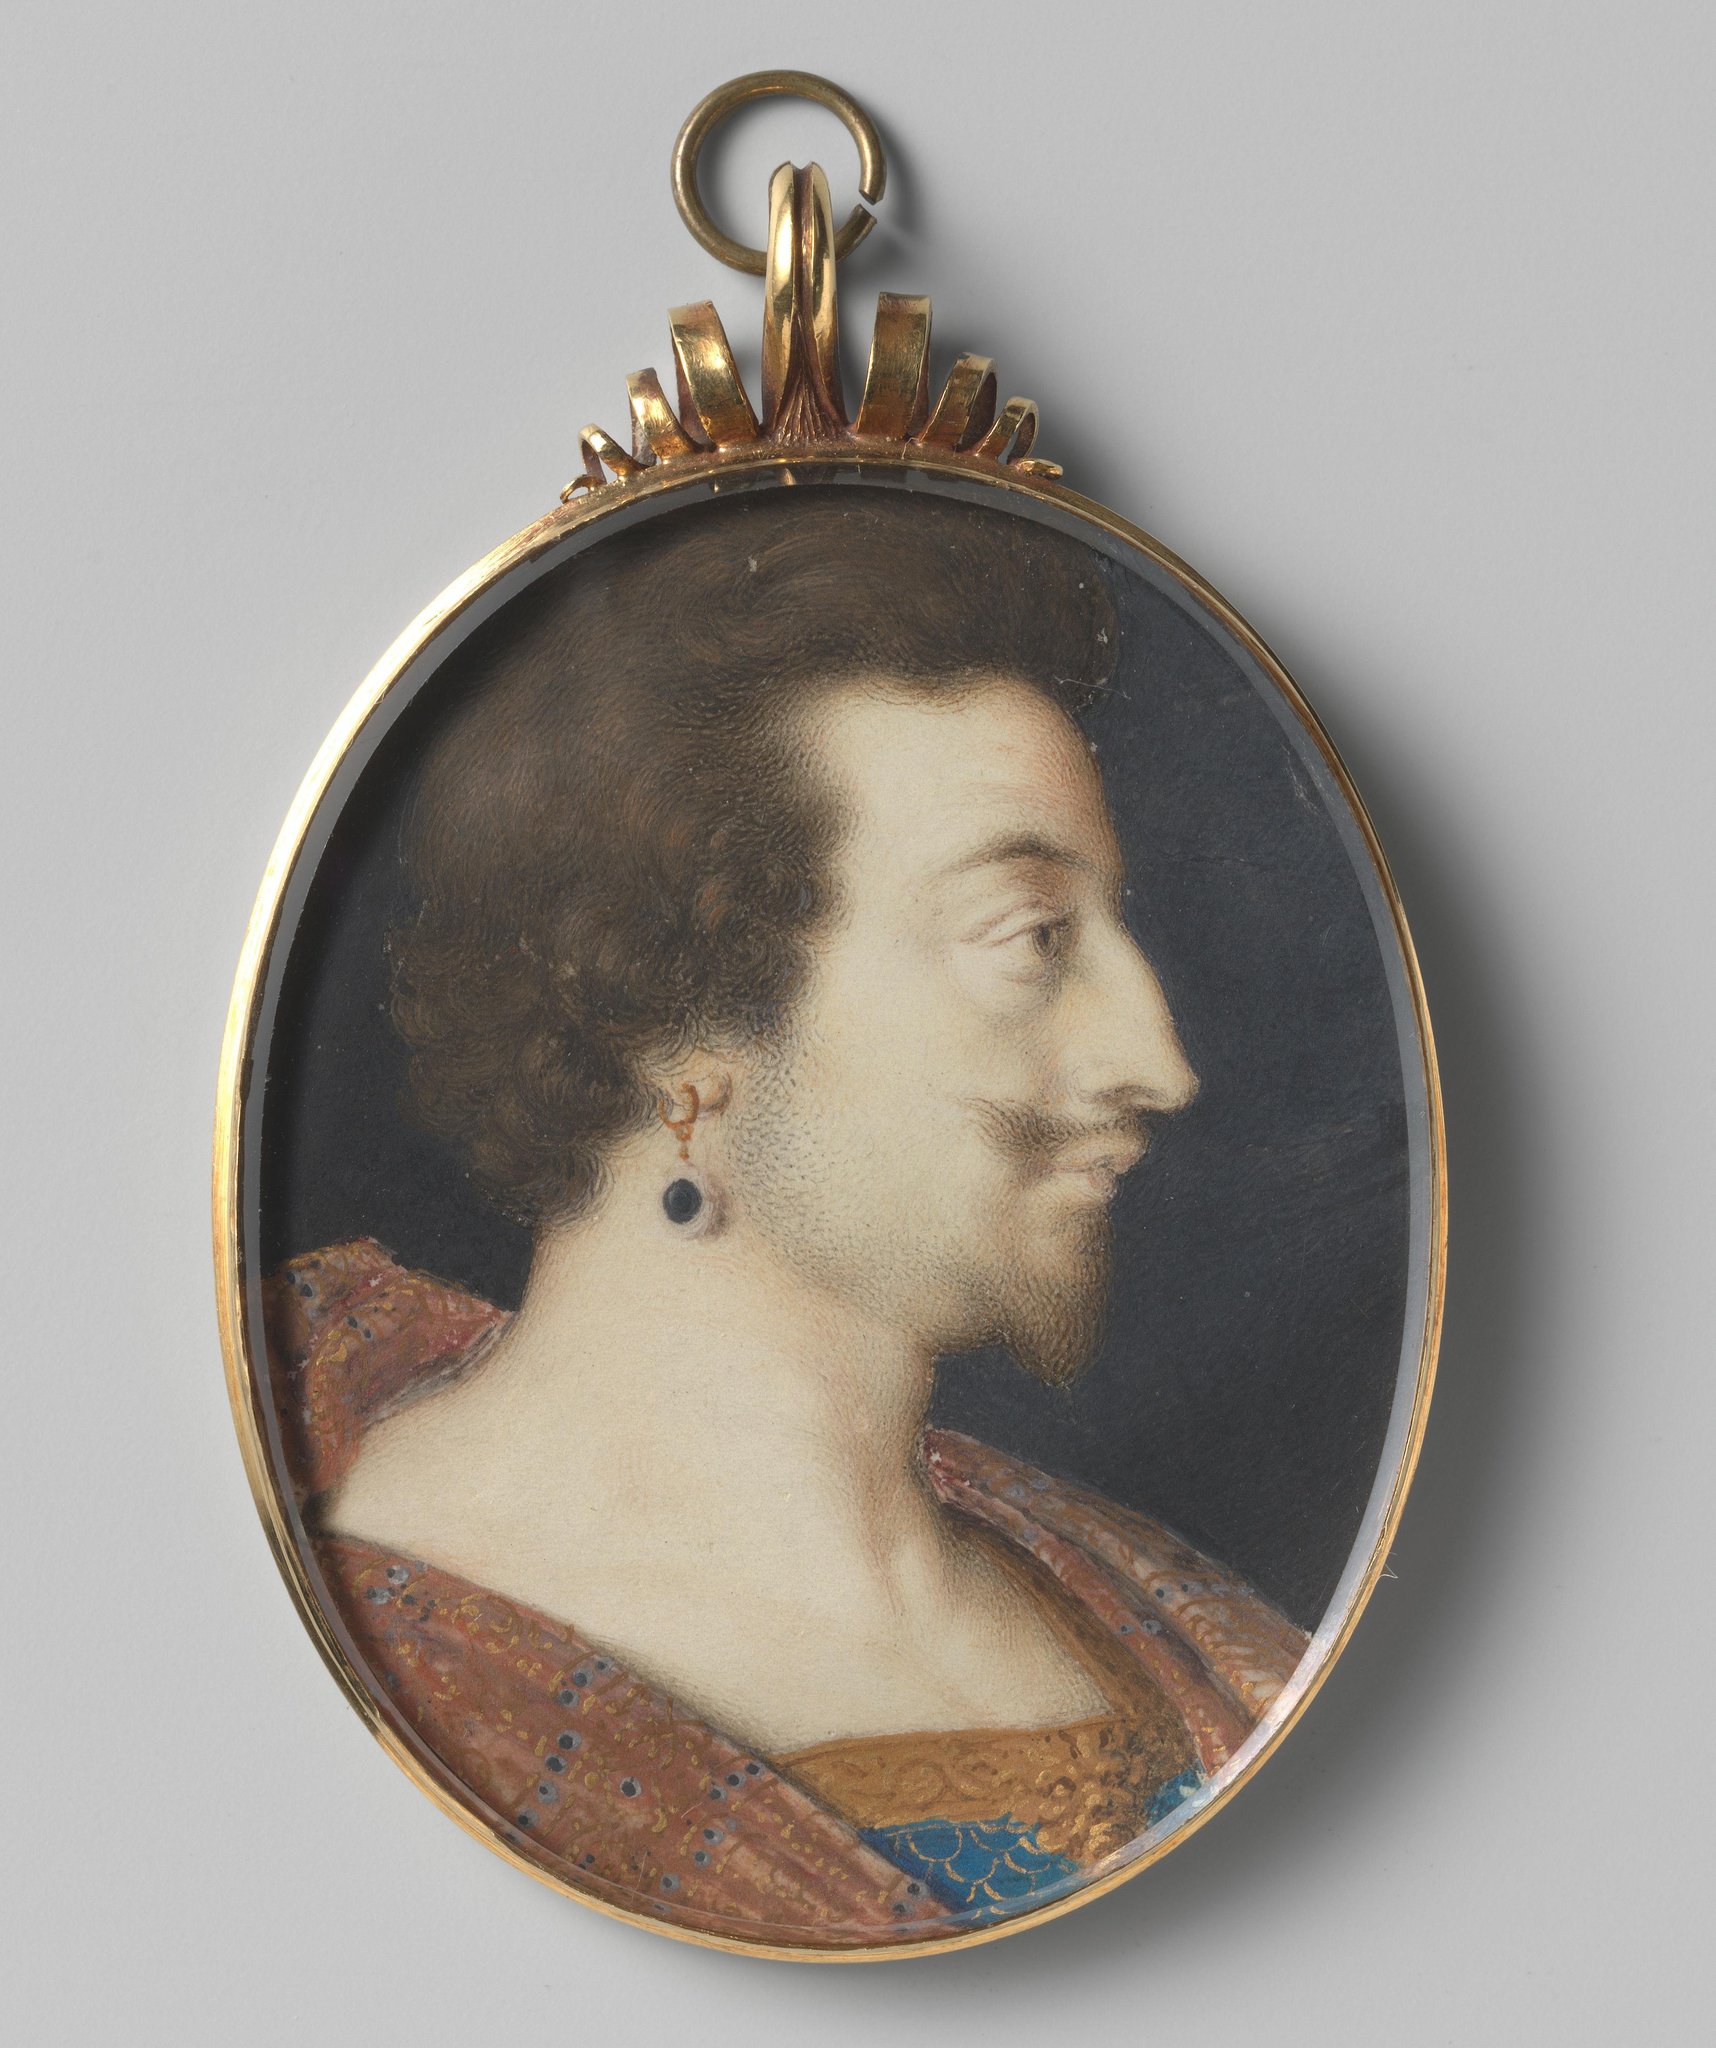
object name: painting, miniature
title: George Villiers (1592-1628), hertog van Buckingham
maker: peter oliver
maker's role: print maker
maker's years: 1594-1647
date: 1612-1647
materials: cardboard, glass, gold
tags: george villiers (1st duke of buckingham)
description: Portret van George Villiers (1592-1628), hertog van Buckingham. Buste, in profiel naar rechts, met oorbel. Onderdeel van de collectie portretminiaturen.